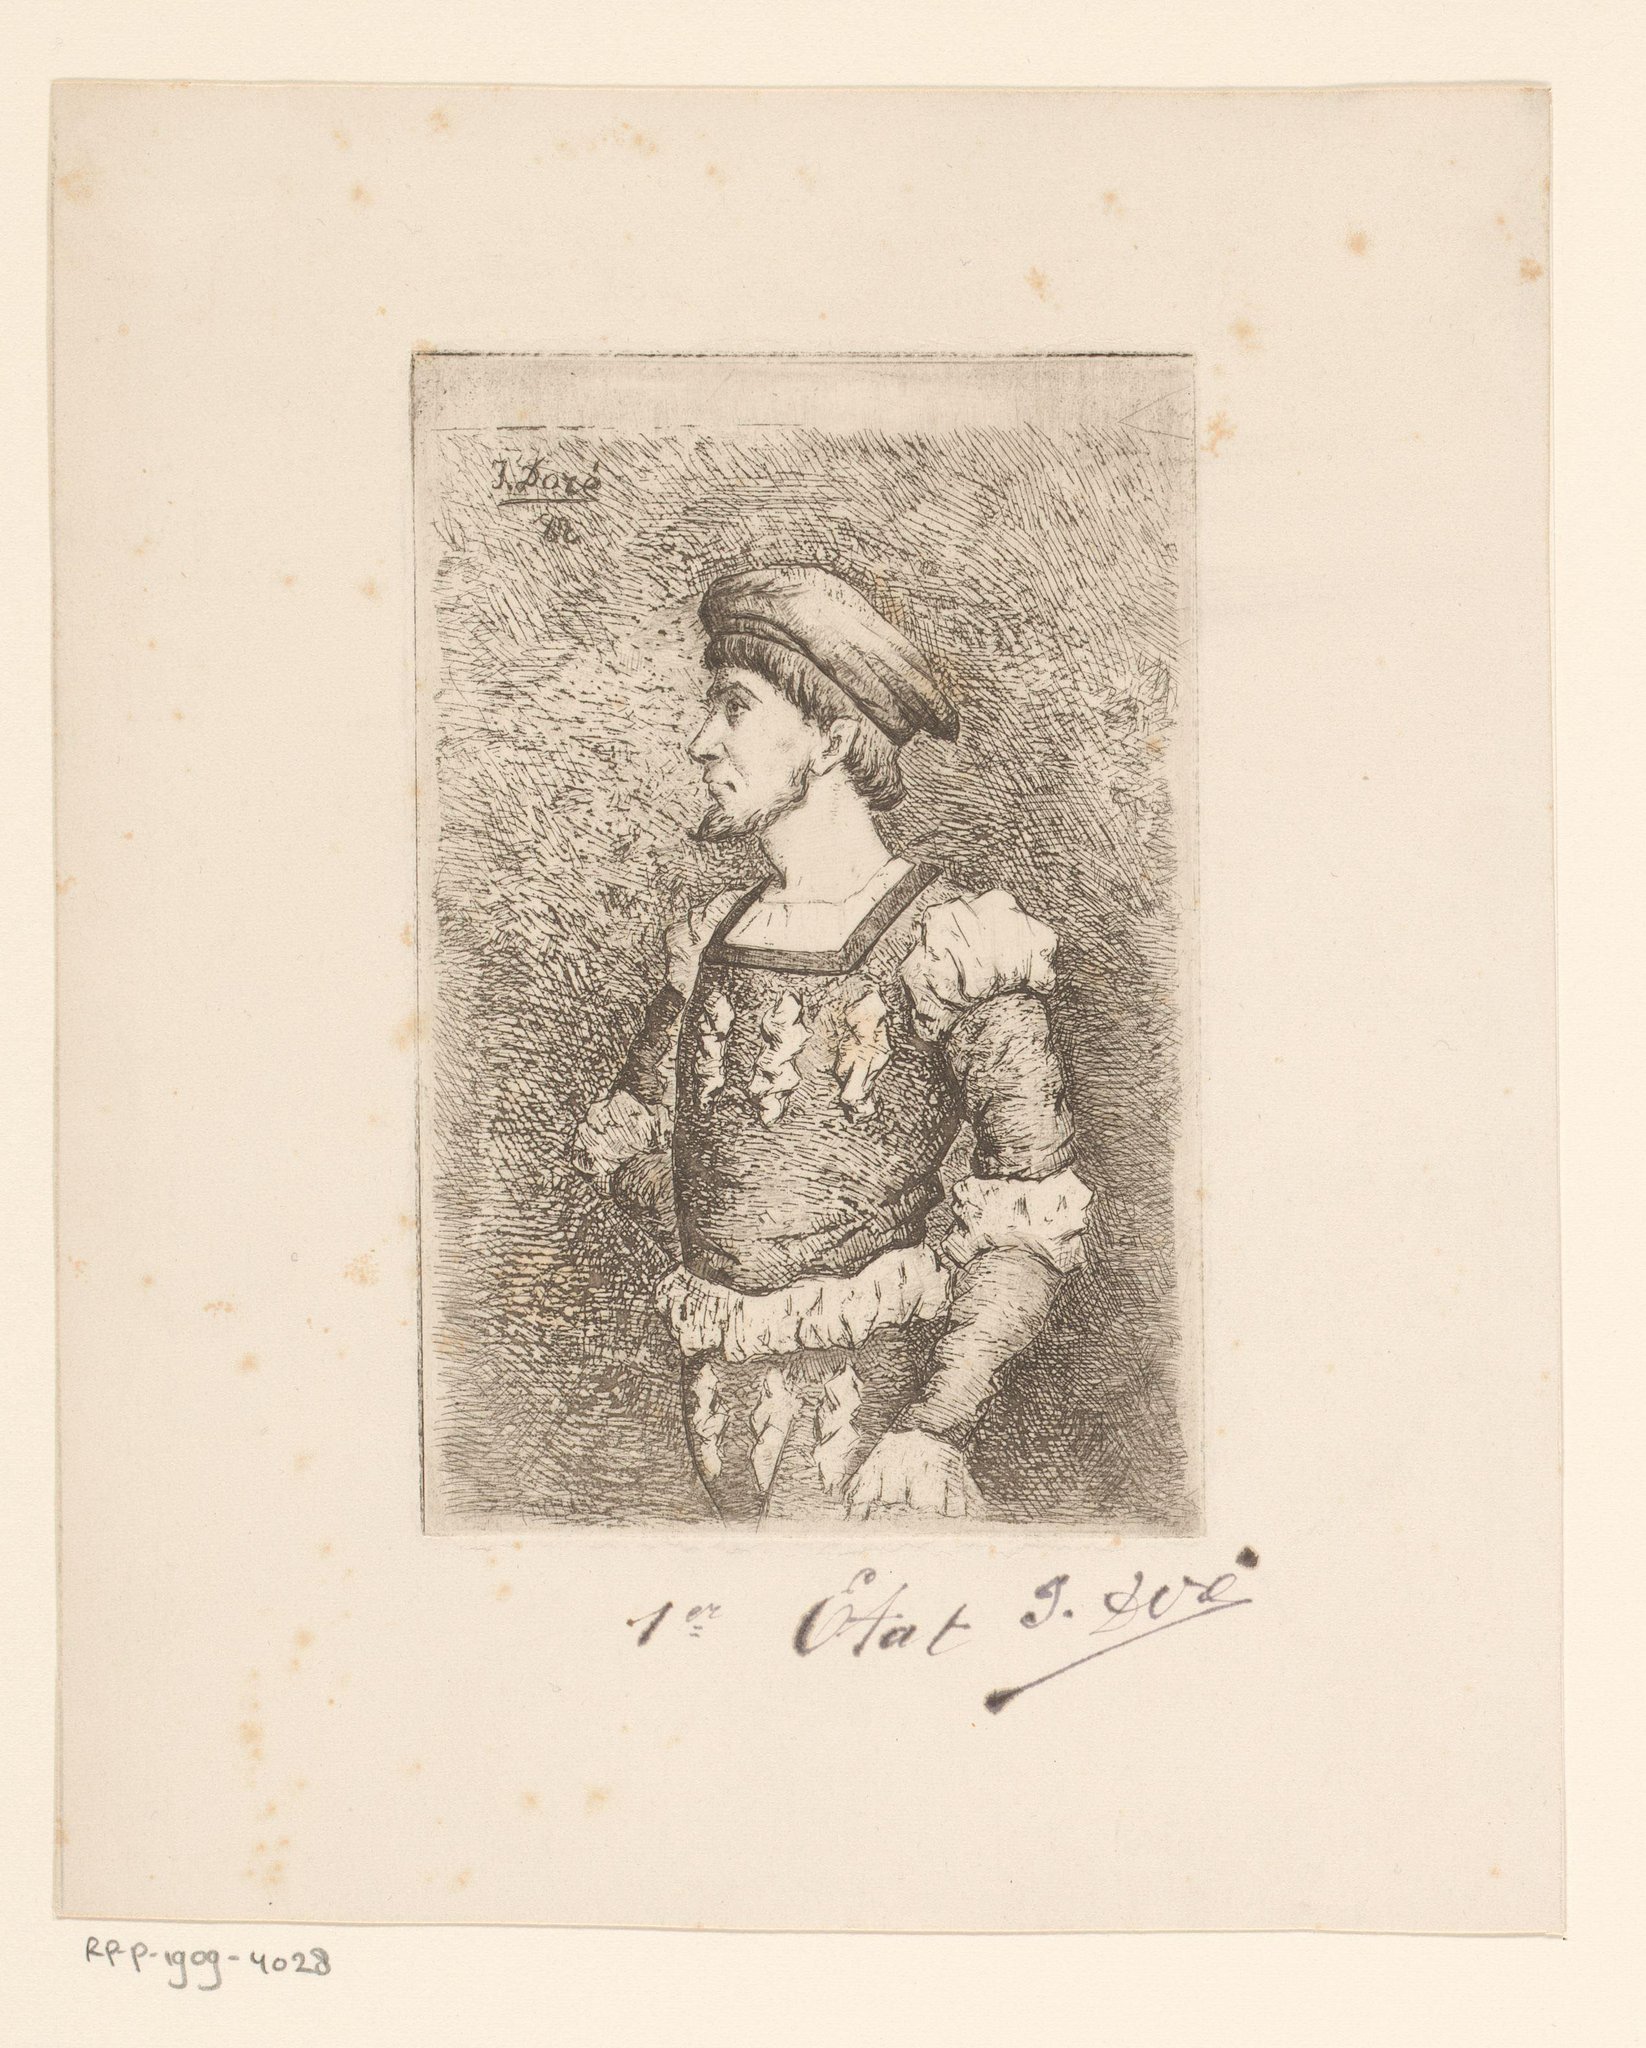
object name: print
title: Edelknaap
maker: jacques doré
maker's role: print maker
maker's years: 1861-1929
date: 1882-1888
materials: paper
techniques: etching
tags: page, footboy, house personnel, servants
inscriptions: inscription: ‘1er Etat’, collector's mark: Lugt 2228